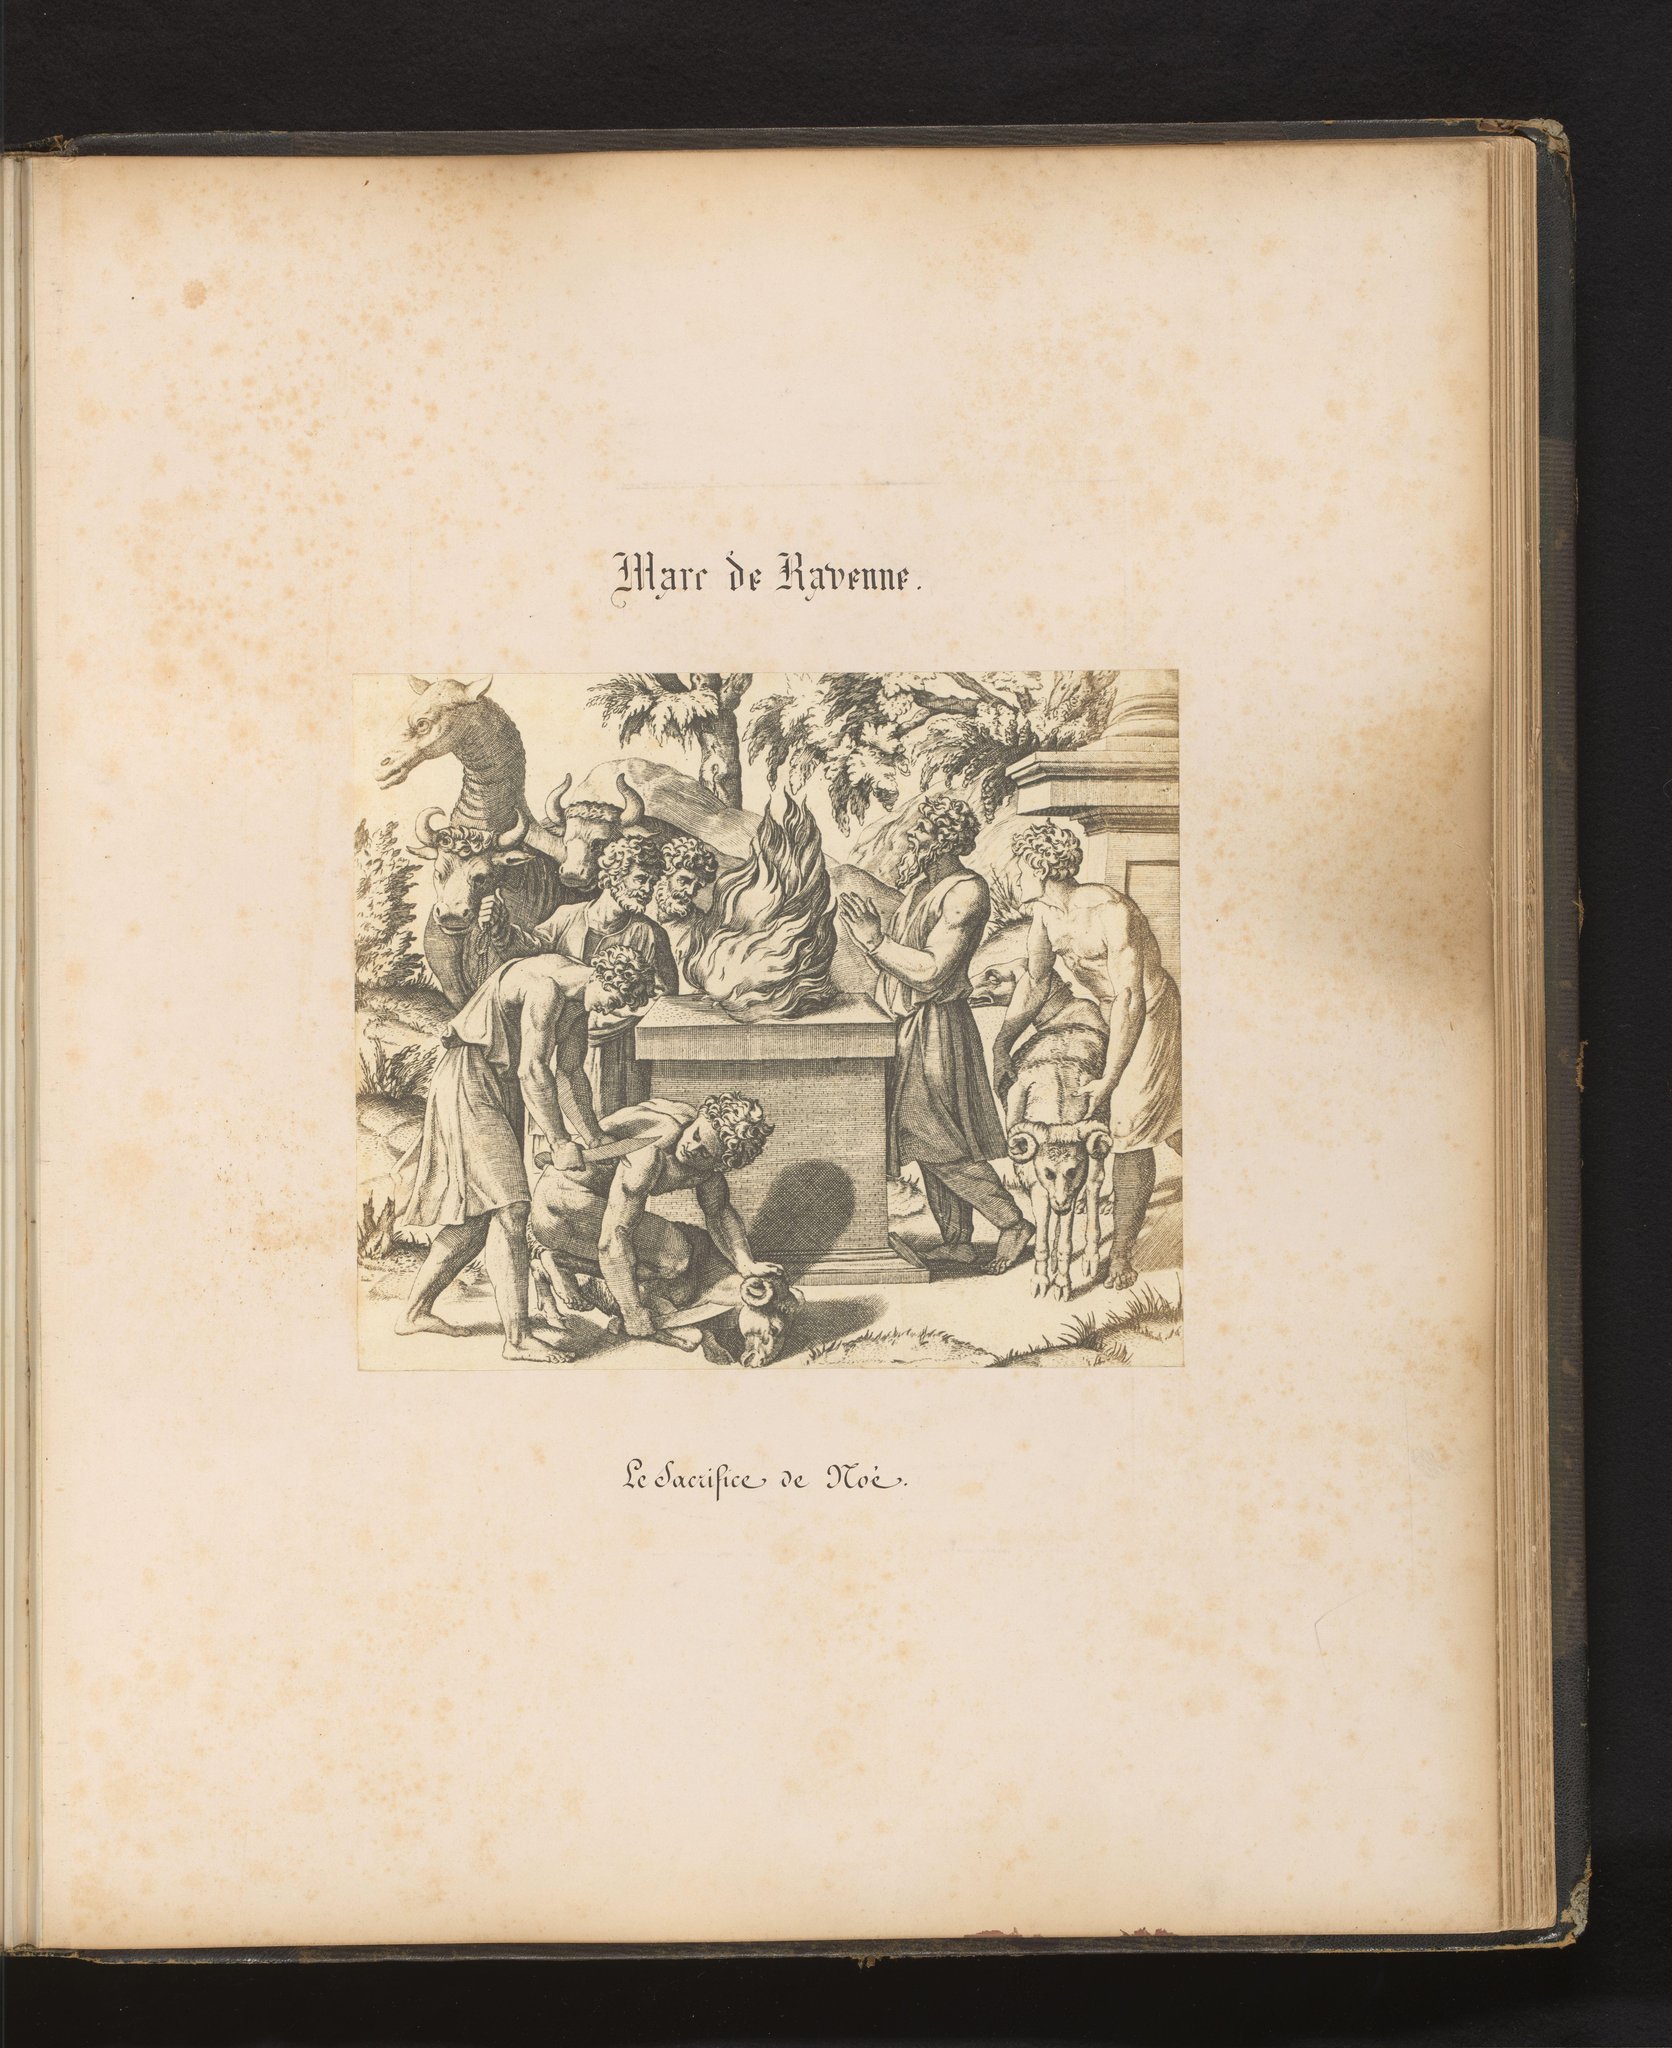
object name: page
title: Marc Antoine Raimondi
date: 1848-1853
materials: photographic support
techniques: salted paper print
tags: noah's sacrifice; various animals are offered, possibly a lamb, a dove and a ram (often combined with the rainbow of the covenant)